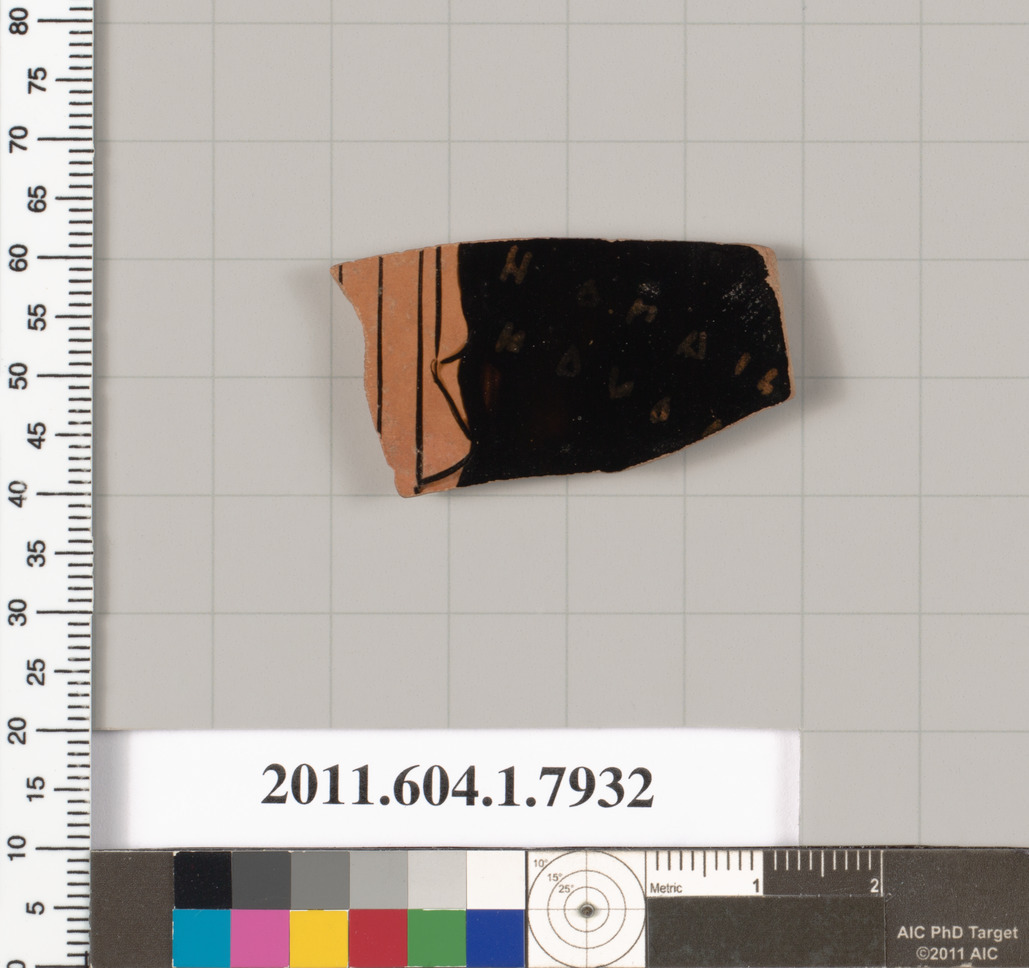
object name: kylix fragment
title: Terracotta fragment of a kylix (drinking cup)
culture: greek, attic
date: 460-450 BCE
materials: terracotta